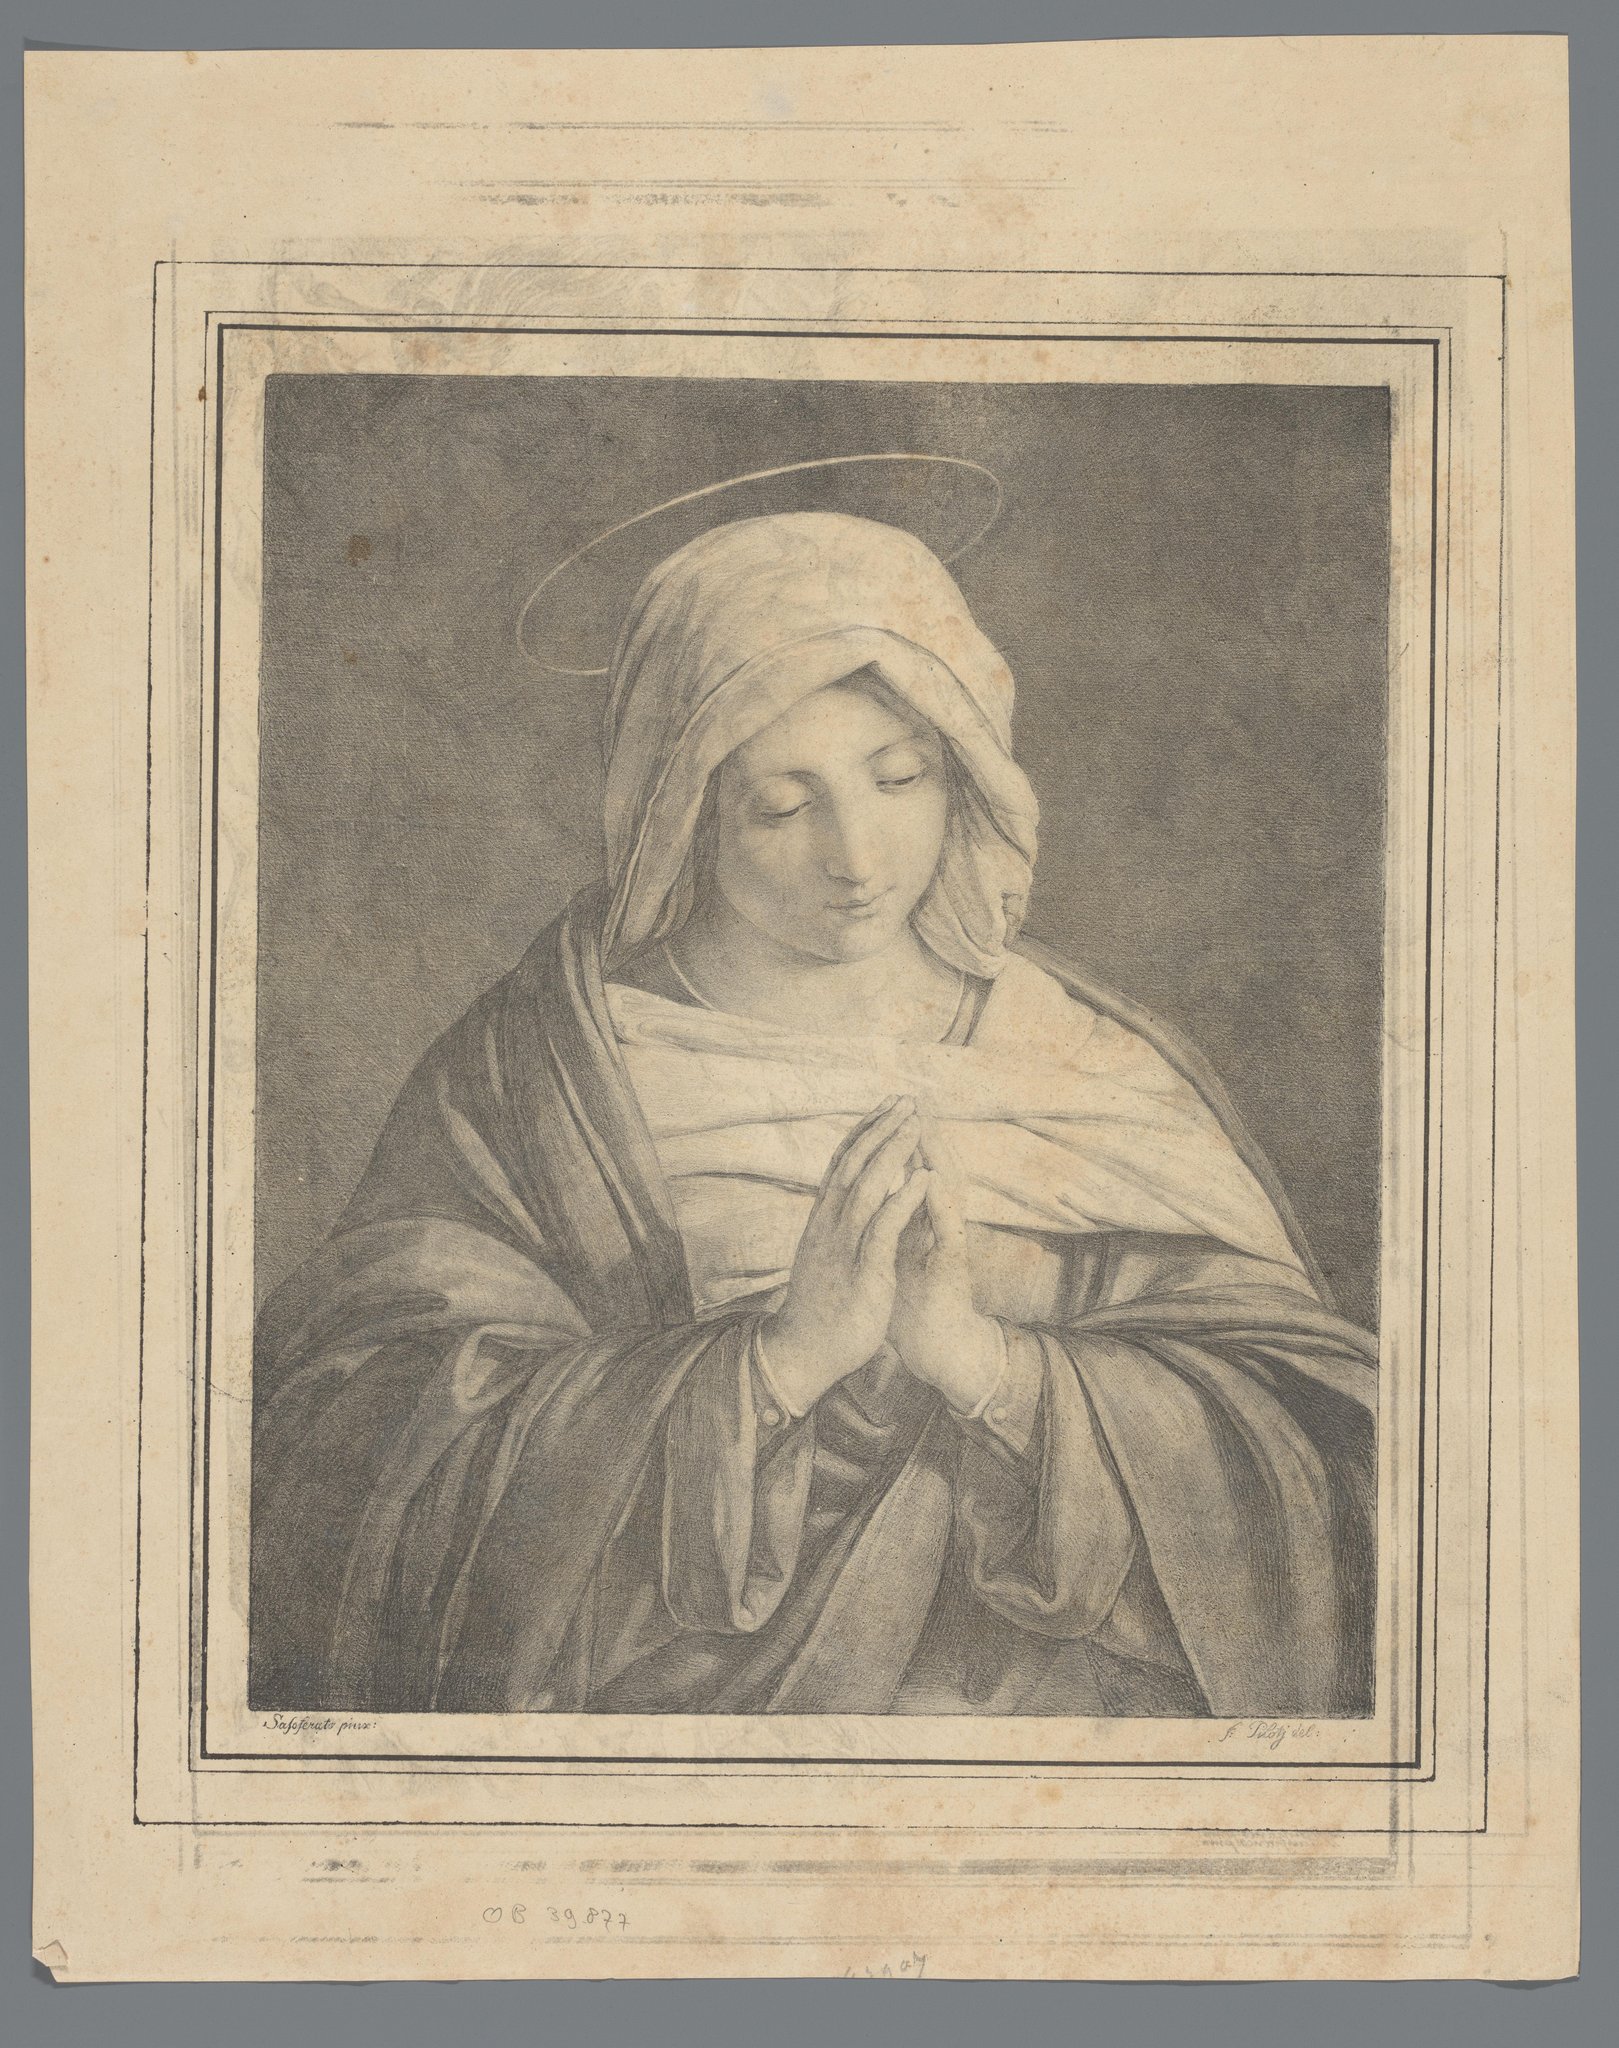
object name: print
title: Maria in gebed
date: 1810-1821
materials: paper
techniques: lithograph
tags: mary (without the christ-child), hands folded, radiance emanating from persons or things